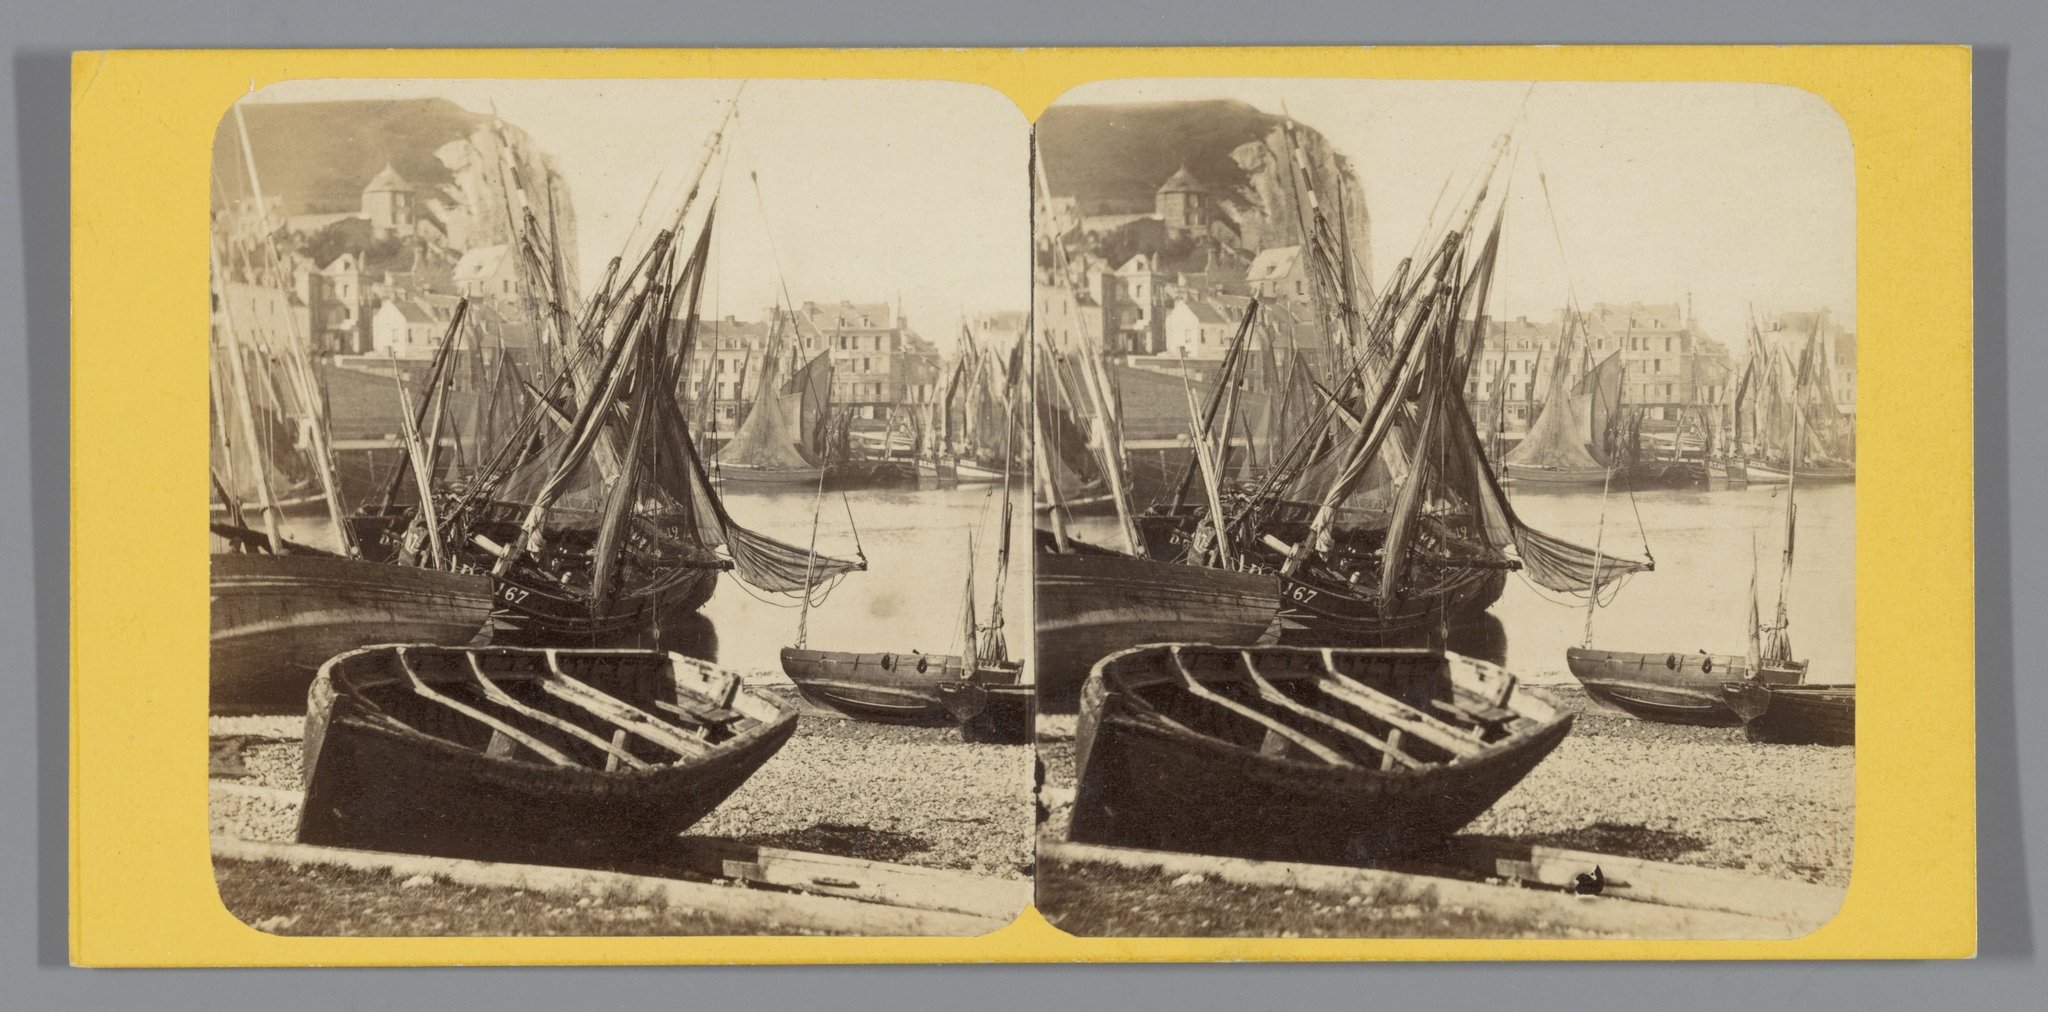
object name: stereograph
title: La France Maritime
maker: Anonymous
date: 1860-1880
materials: cardboard, photographic support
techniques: albumen print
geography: le tréport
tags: ships, boats on land, beached